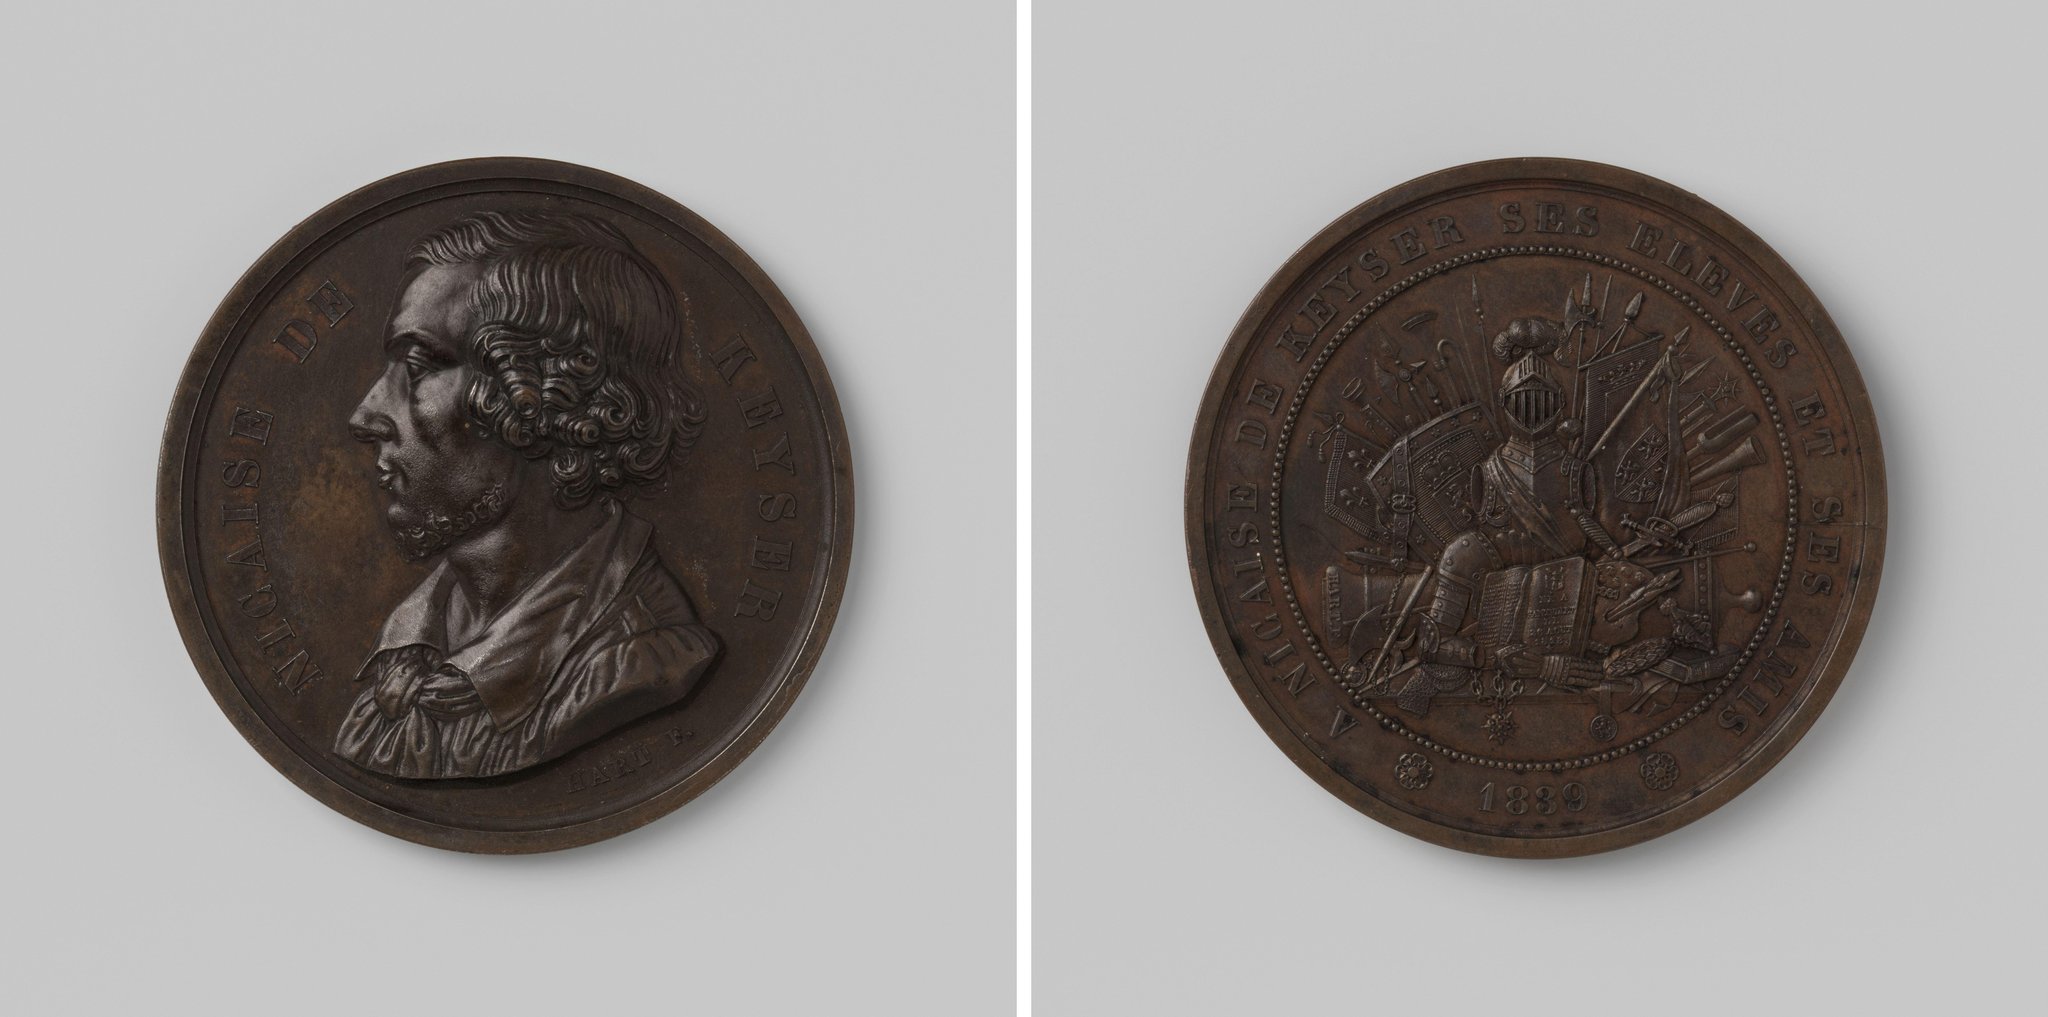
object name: honorary medal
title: Nicaise de Keyser, penning geslagen door zijn leerlingen en vrienden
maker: laurent joseph hart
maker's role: die cutter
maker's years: 1810-1860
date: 1839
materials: bronze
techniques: striking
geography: brussels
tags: nicaise de keyser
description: Bronzen penning. Voorzijde: borststuk man binnen omschrift. Keerzijde: trophee, opgebouwd uit wapentuigen artistieke voorwerpen binnen omschrift